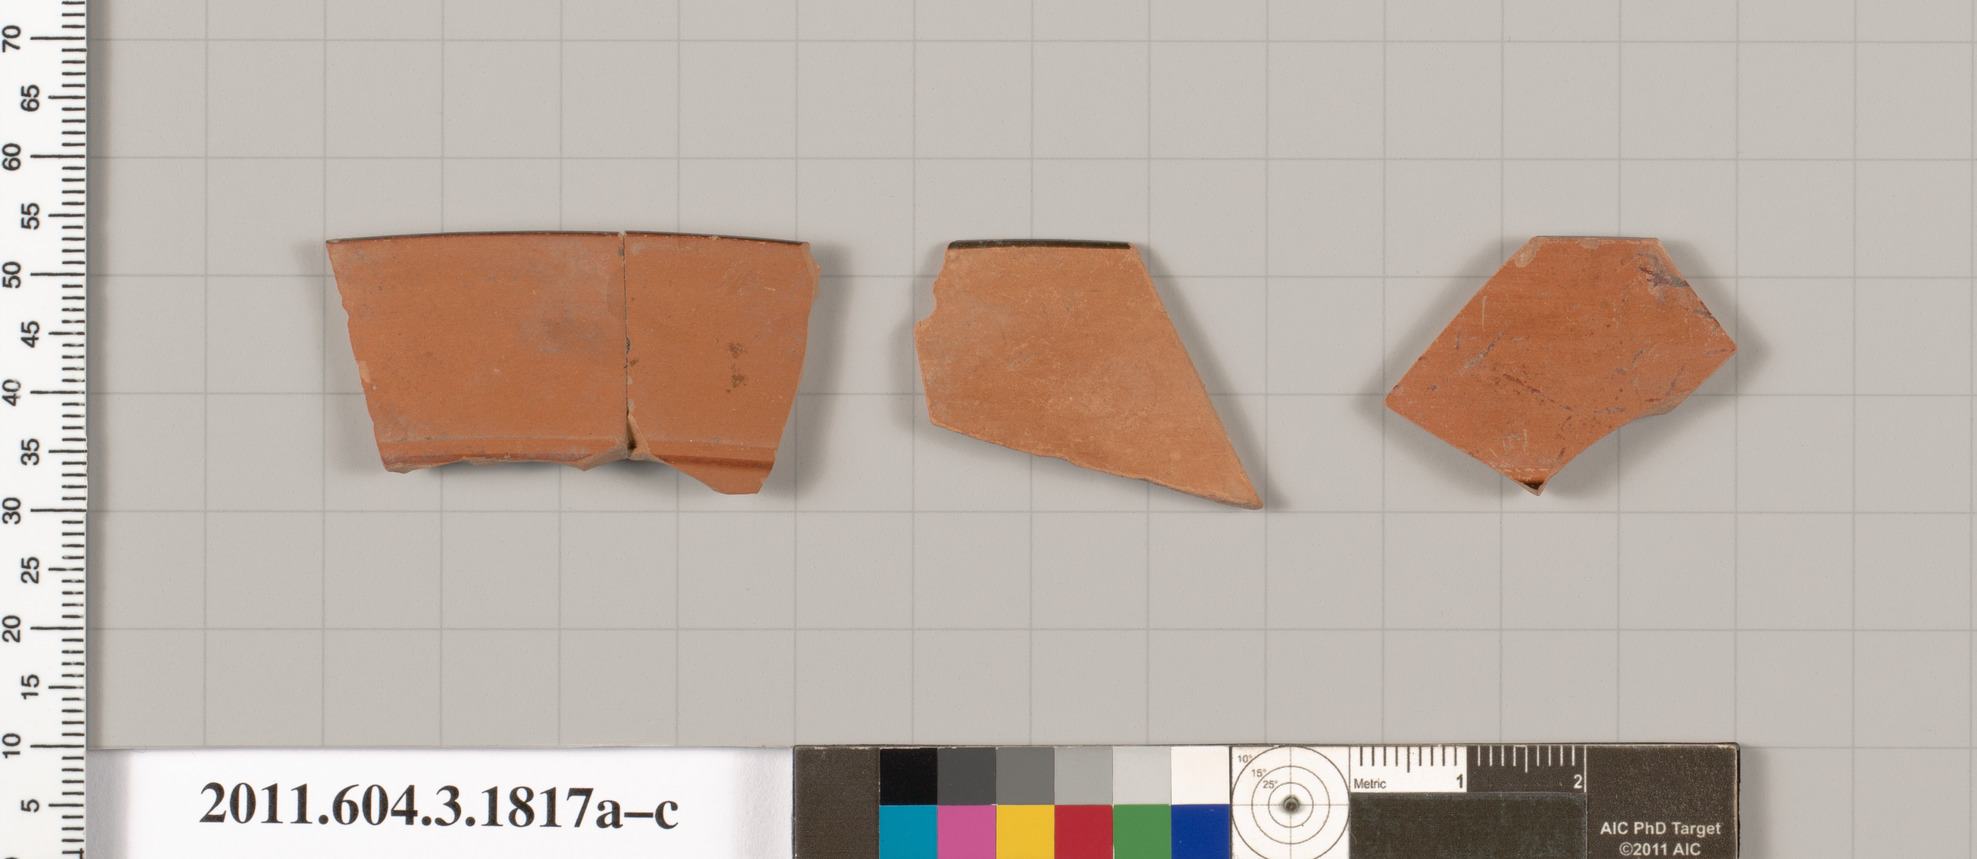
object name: kylix fragment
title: Terracotta rim fragments of kylikes: Lip cup (drinking cup)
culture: greek, attic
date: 560-525 BCE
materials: terracotta